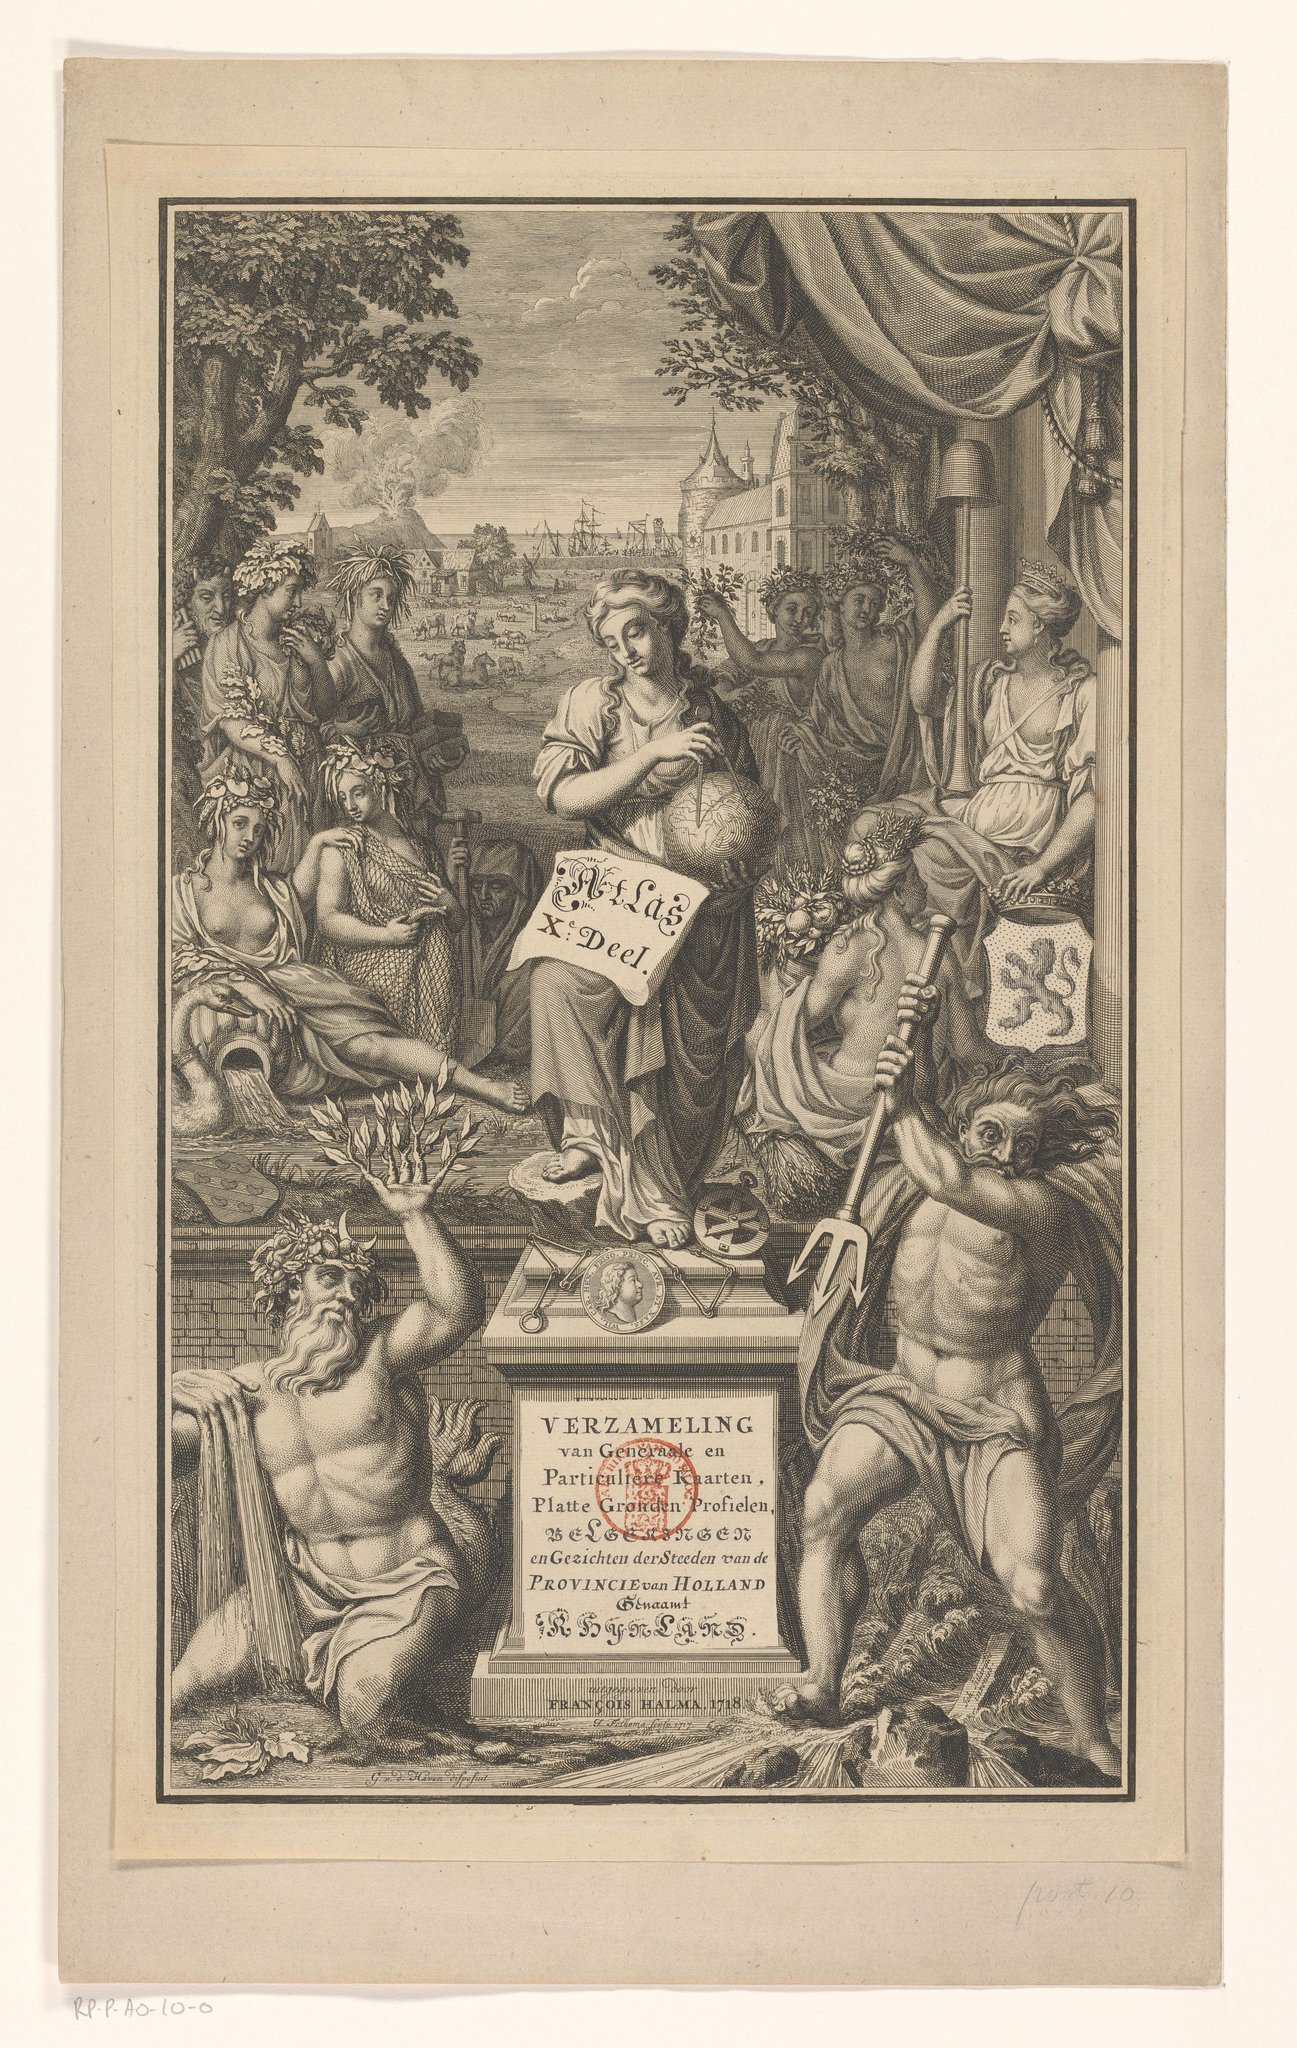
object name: print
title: Verzameling van Generaale en Particuliere Kaarten, Platte Gronden Profielen, Belegeringen en Gezichten der Steeden van de Provincie van Holland Genaamt Rhynland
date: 1717-1718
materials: ink, paper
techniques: engraving, etching, pen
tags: commercial fishery, (story of) ceres (demeter), peat-cutting, 'astronomia', 'cosmografia'; 'cosmografia' (ripa), personifications of countries, nations, states, districts, etc., river-gods, 'corografia', 'geografia', 'hidrografia' (ripa), agriculture, fruitfulness, productiveness, fertility, fecundity; 'fecondità' (ripa), (story of) flora, coat of arms (as symbol of the state, etc.) (+ province; provincial), neptune as lord of the sea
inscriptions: collector's mark: Lugt 19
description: Deze prent is hier gebruikt als titelprent van een deel van een ongebonden atlas; een verzameling cartografische en topografische prenten en tekeningen. Oorspronkelijk was de prent echter bedoeld als titelpagina voor een gebonden atlas met kaarten van Friesland, waardoor een deel van de hier volgende beschrijving betrekking heeft op die context. Op het voetstuk in het midden staat de personificatie van de cartografie, met in haar hand een aardbol die ze met een passer meet. Op haar bovenbeen rust een blad met het handgeschreven deel van de atlas (oorspronkelijk een kaart van Friesland). Aan haar voeten een meetketting, een rond (land)meetkundig instrument en een portret van Willem IV van Oranje-Nassau. Daaronder de handgeschreven titel van dit deel van de atlas. Ze houdt een wakend oog op Wispelturigheid (Wispeltuer), linksonder. Oorspronkelijk staat hij voor de wispelturigheid waar het Friese land zich naar moest schikken: een bos kon opeens onder water staan, want zijn lichaam smelt door het zoute water van de zee. Linksboven zijn hoofd een wapenschild met het wapen van Friesland (met schuinbalken en pompeblêden). De dreiging van de zee is rechtsonder verbeeld door een onstuimige Neptunus (Zeevoogd). Links en rechts van Cartografie nog meer figuren die oorspronkelijk betrekking hadden op Friesland en haar vruchtbare natuur, visserij en landbouw. Links, met haar arm leunend op een kruik waar water uitstroomt, een stroomgodin (Stroomvoogdess) met rechts van haar de personificatie van de visserij (Visschevang). Boven hen van links naar rechts: een sater met fluit als personificatie van de natuur (Natuer), de personificatie van de bossen met eikenloven (Woudman) en personificatie van de turfwinning (vrouw Veenbrand). Rechtsonder haar vrouw Onland, die rouwt om de schade die de turfwinning aan het land veroorzaakt. Rechts van Cartografie zit Flora en/of Ceres (vrouw Veldgewas) met korenaren en cornucopia, ze staat voor de overvloed die voortvloeit uit het land. Boven haar, op de achtergrond, twee vrouwelijke personificaties die in verband staan met groene weides en/of grasvelden: Beemdeheil en Graazevol. Rechts, met in haar ene hand een bazuin met daarop een vrijheidshoed en in de andere hand een schild met het wapen van Holland, de personificatie van het gebied van dit deel van de atlas (oorspronkelijk de Friese Maagd met het provinciewapen met twee leeuwen). Op de achtergrond een landschap met kenmerkende Friese elementen, zoals het Sjaerdemaslot te Franeker en de vuurspuwende Rode Klif te Gaasterland (zou in de oudheid een vulkaan zijn geweest).